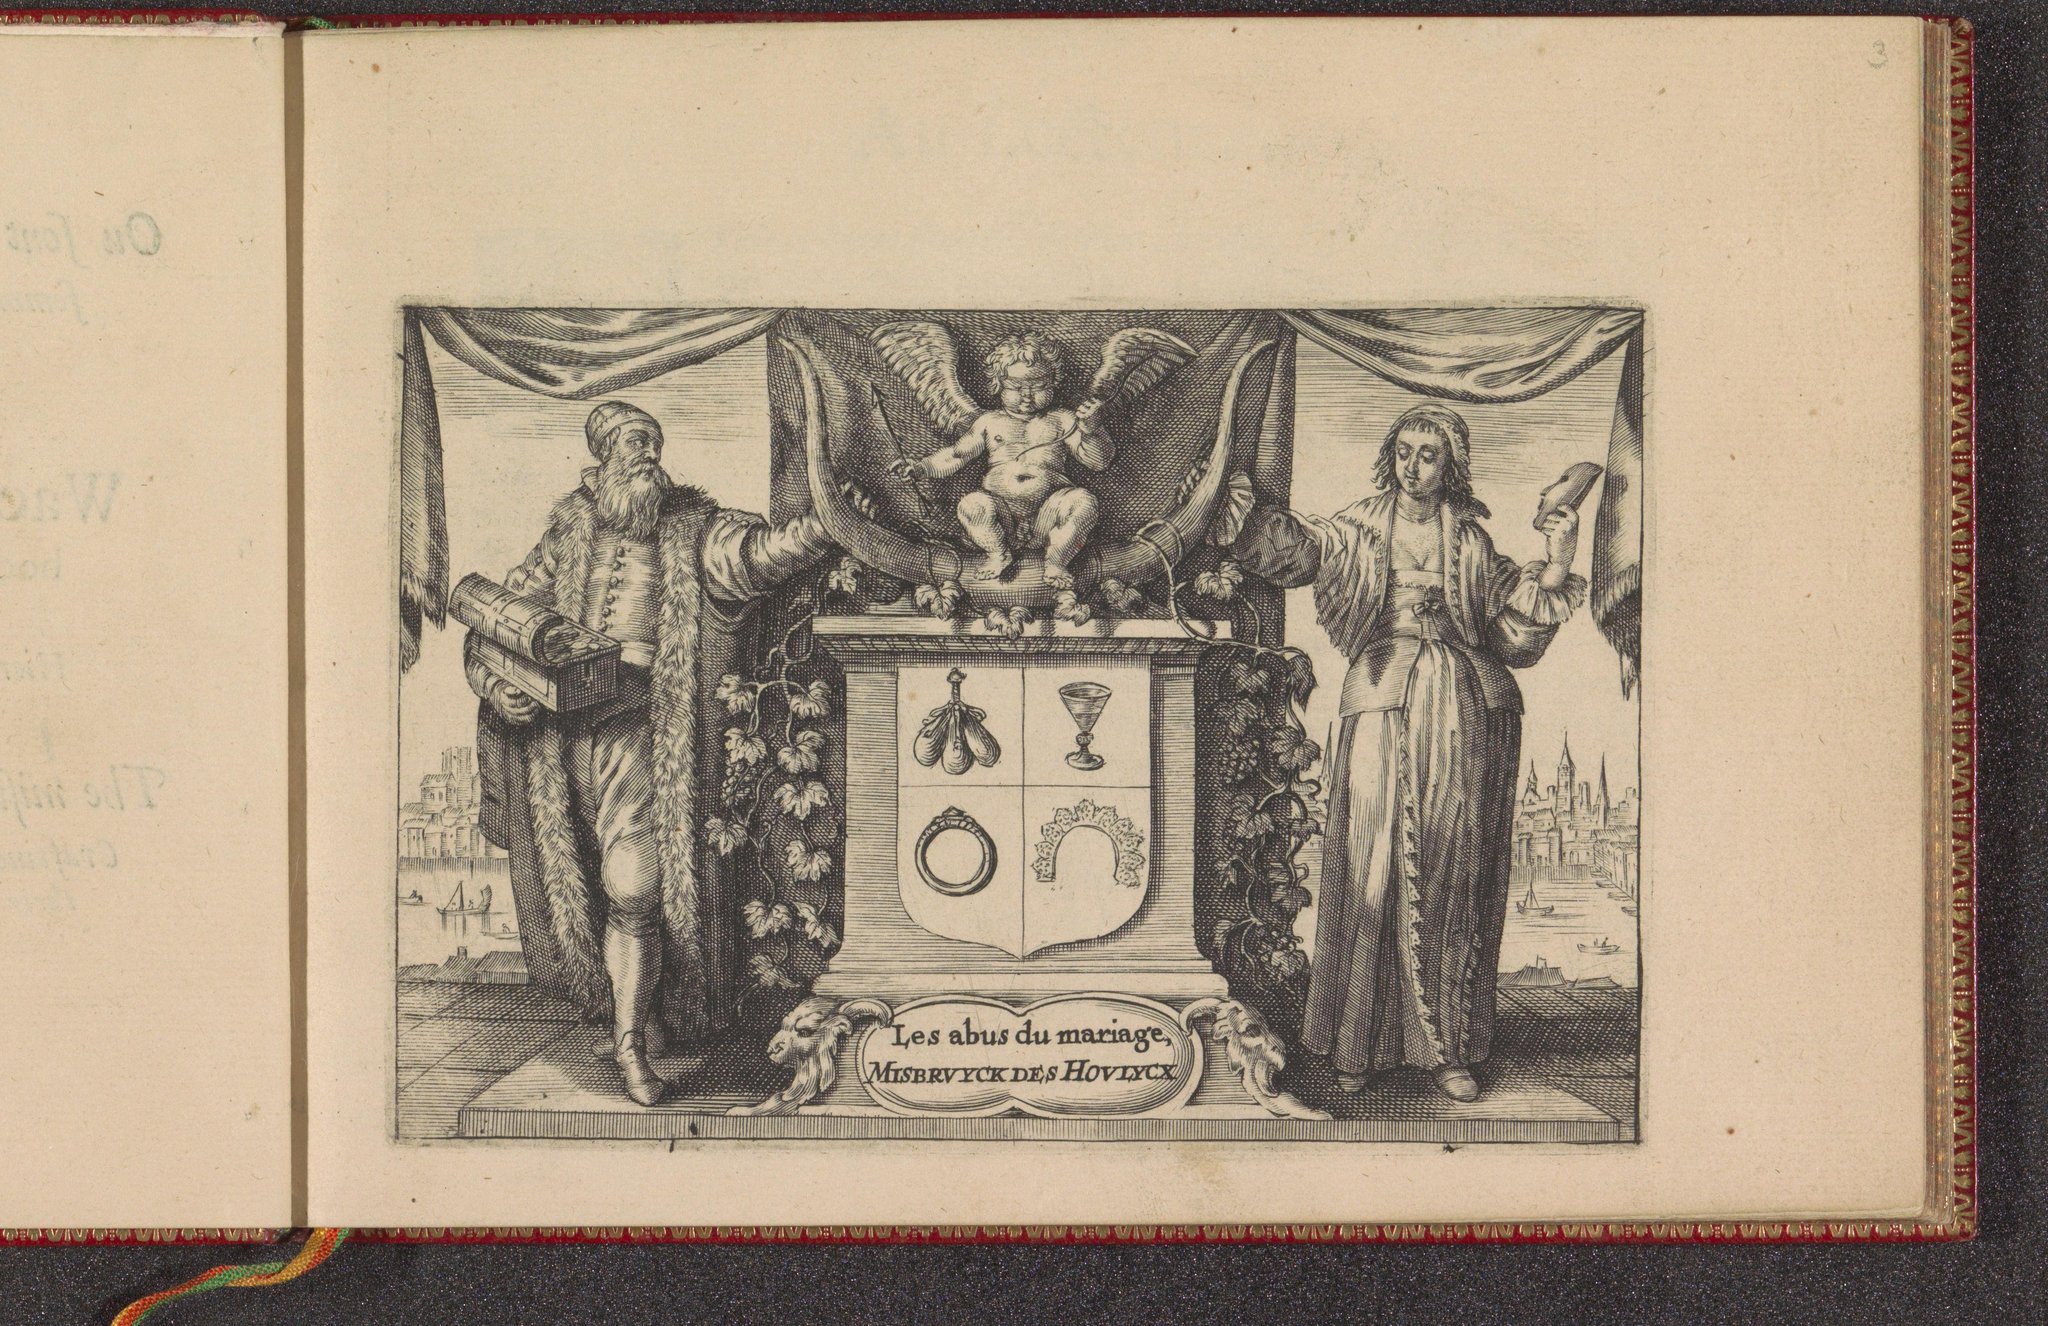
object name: titelprent, frontispice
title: Les abus du mariage, / misbruyck des houlycx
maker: crispijn van de passe (ii)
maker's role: draughtsman, print maker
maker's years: 1594-1670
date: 1641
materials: paper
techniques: engraving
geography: amsterdam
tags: (story of) cupid, amor (eros), cheat, deceit; 'fraude', 'inganno' (ripa), adultery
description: Allegorische titelprent. De personificaties van de gekochte liefde (met geldkist) en bedrog (met masker) staan links en rechts van een voetstuk waarop Amor zit op een stierenhoorn. Over het voetstuk hangen druivenranken. Op de voorkant symbolen die verwijzen naar overspel: volle geldbuidels, drank, geschenken zoals een ring en een kanten kraag (verwijzend naar het vrouwelijk geslacht). De prent maakt deel uit van een album.